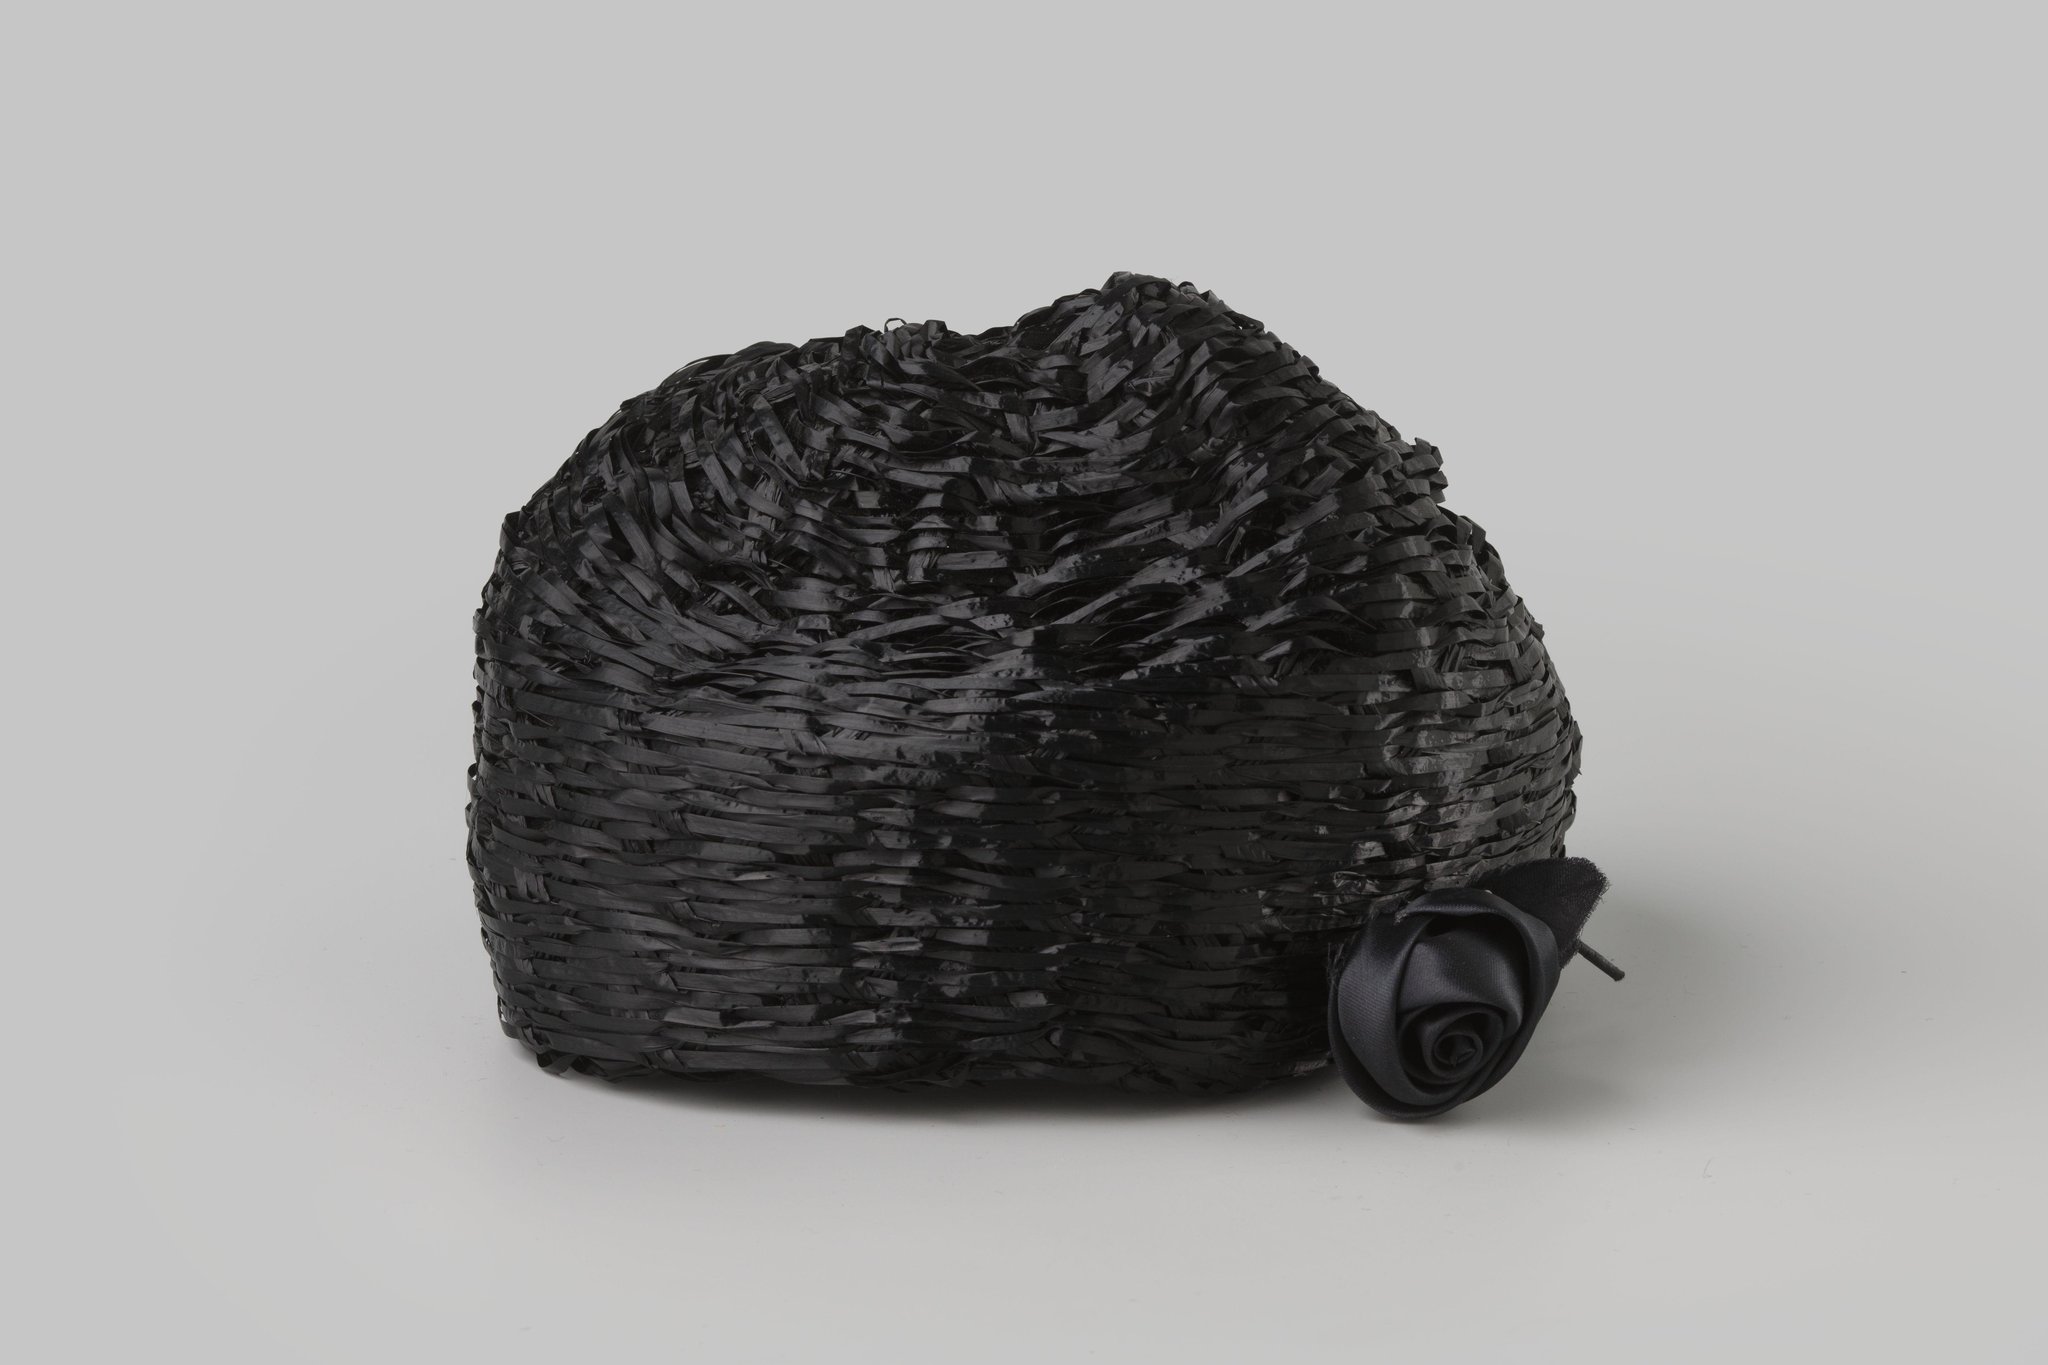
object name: womenswear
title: Hoed van zwart raffia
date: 1950-1970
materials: raffia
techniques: braiding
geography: amsterdam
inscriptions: name: ‘Mode van Itallie-Balvers/ 28 Leidschestraat 28/ Amsterdam’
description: Hoed van zwart raffia met een opgenaaide satijnen zwarte roos.